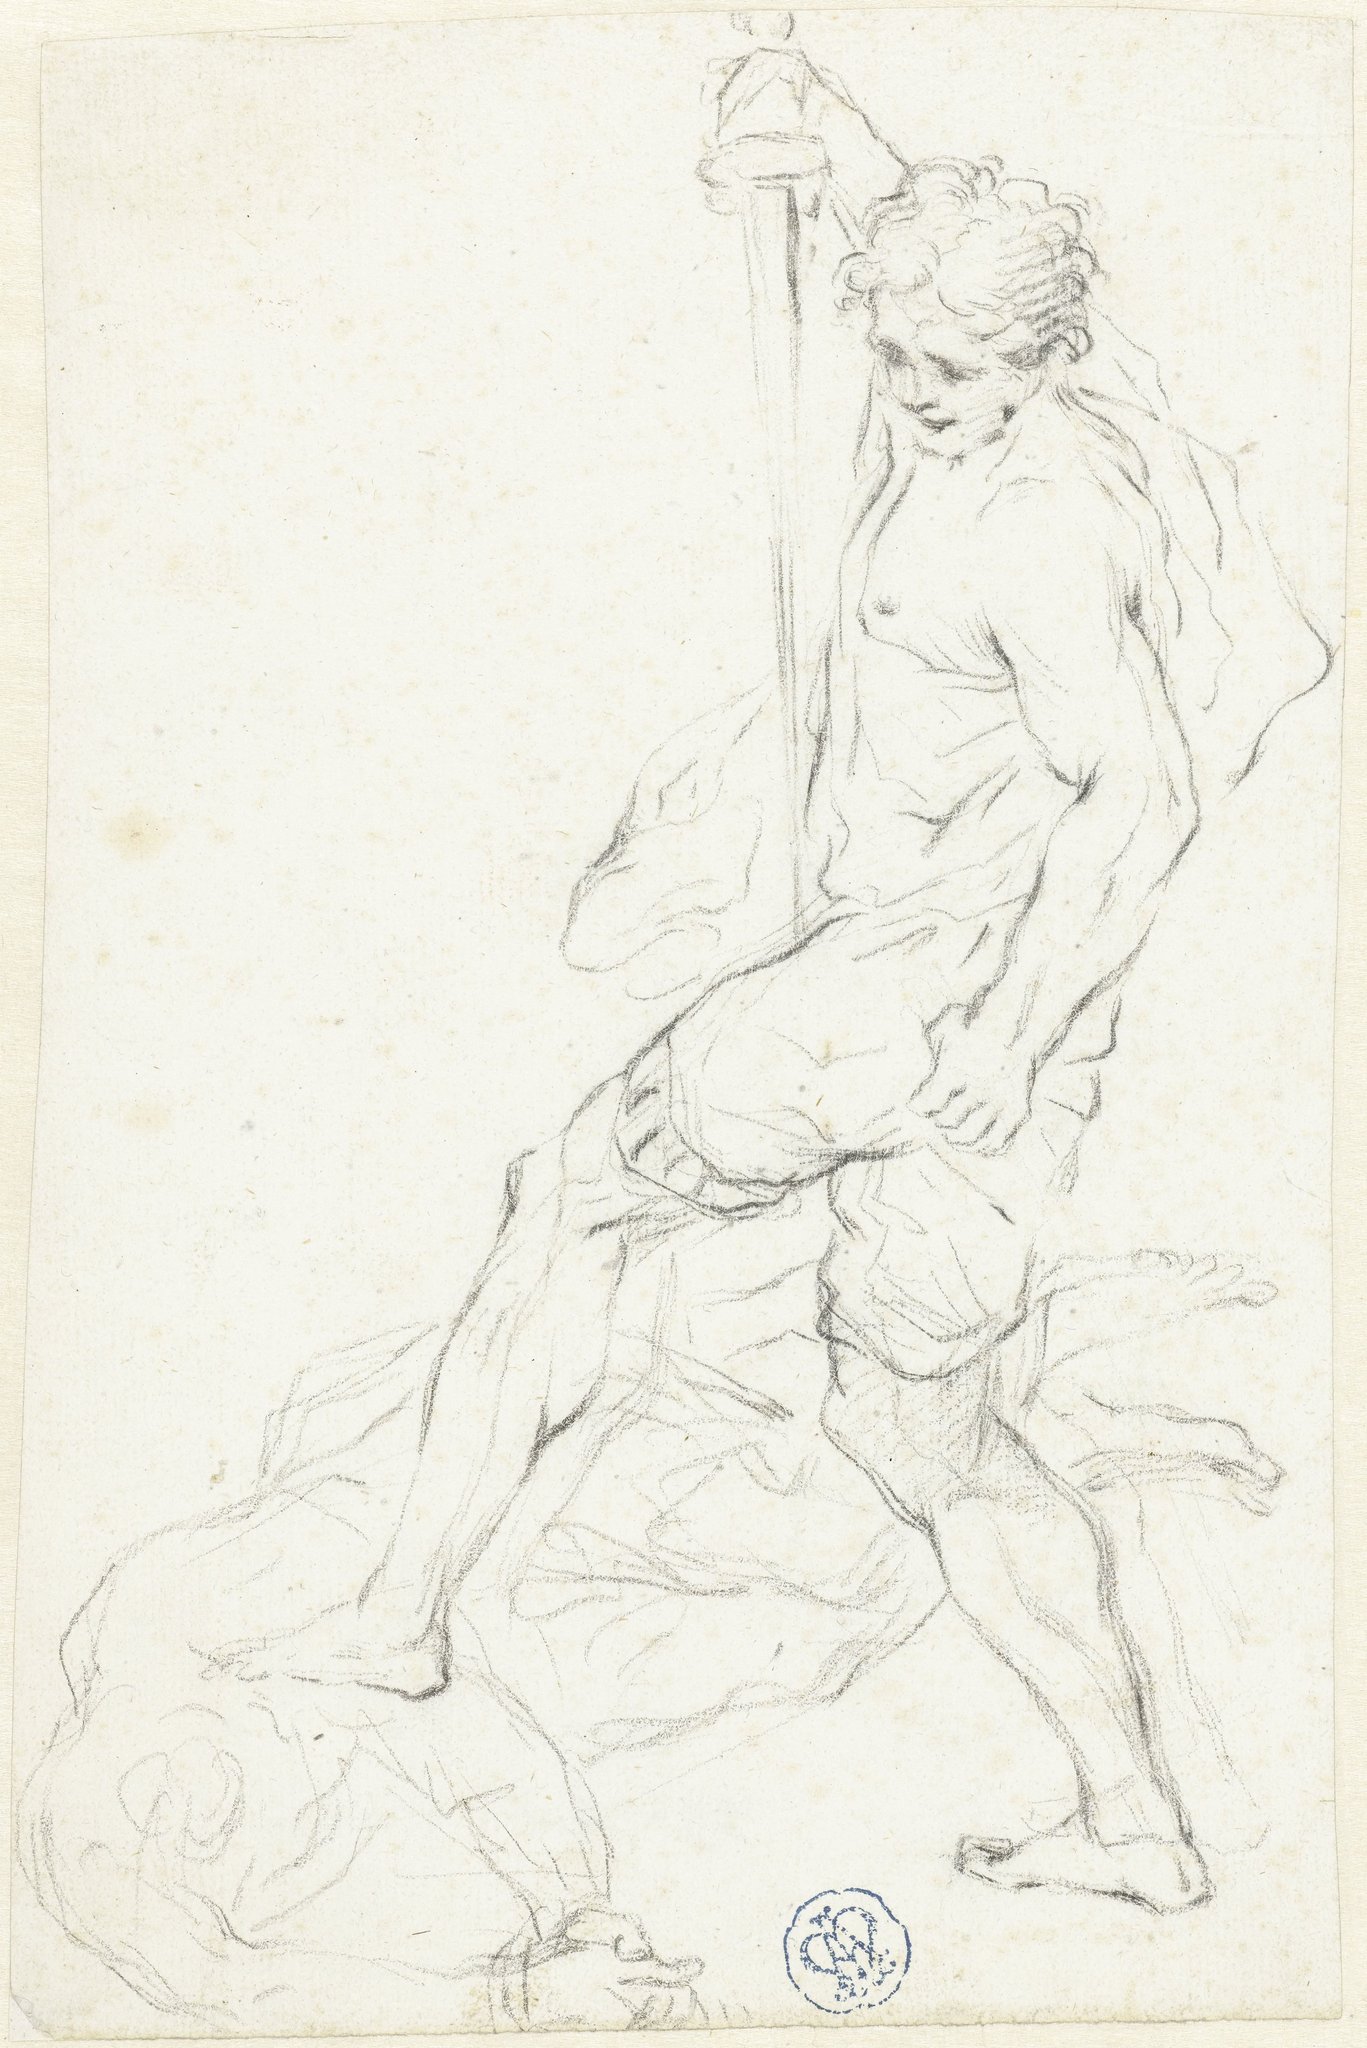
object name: drawing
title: Krijger staand met linkervoet op tegenstander (David en Goliath?)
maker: johann carl loth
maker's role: draughtsman, painter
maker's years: 1632-1698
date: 1642-1698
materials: chalk, paper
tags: david fighting goliath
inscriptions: inscription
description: Een staande krijger met getrokken zwaard, zijn linkervoet rustend op het lichaam van zijn overwonnen tegenstander (David en Goliath?).